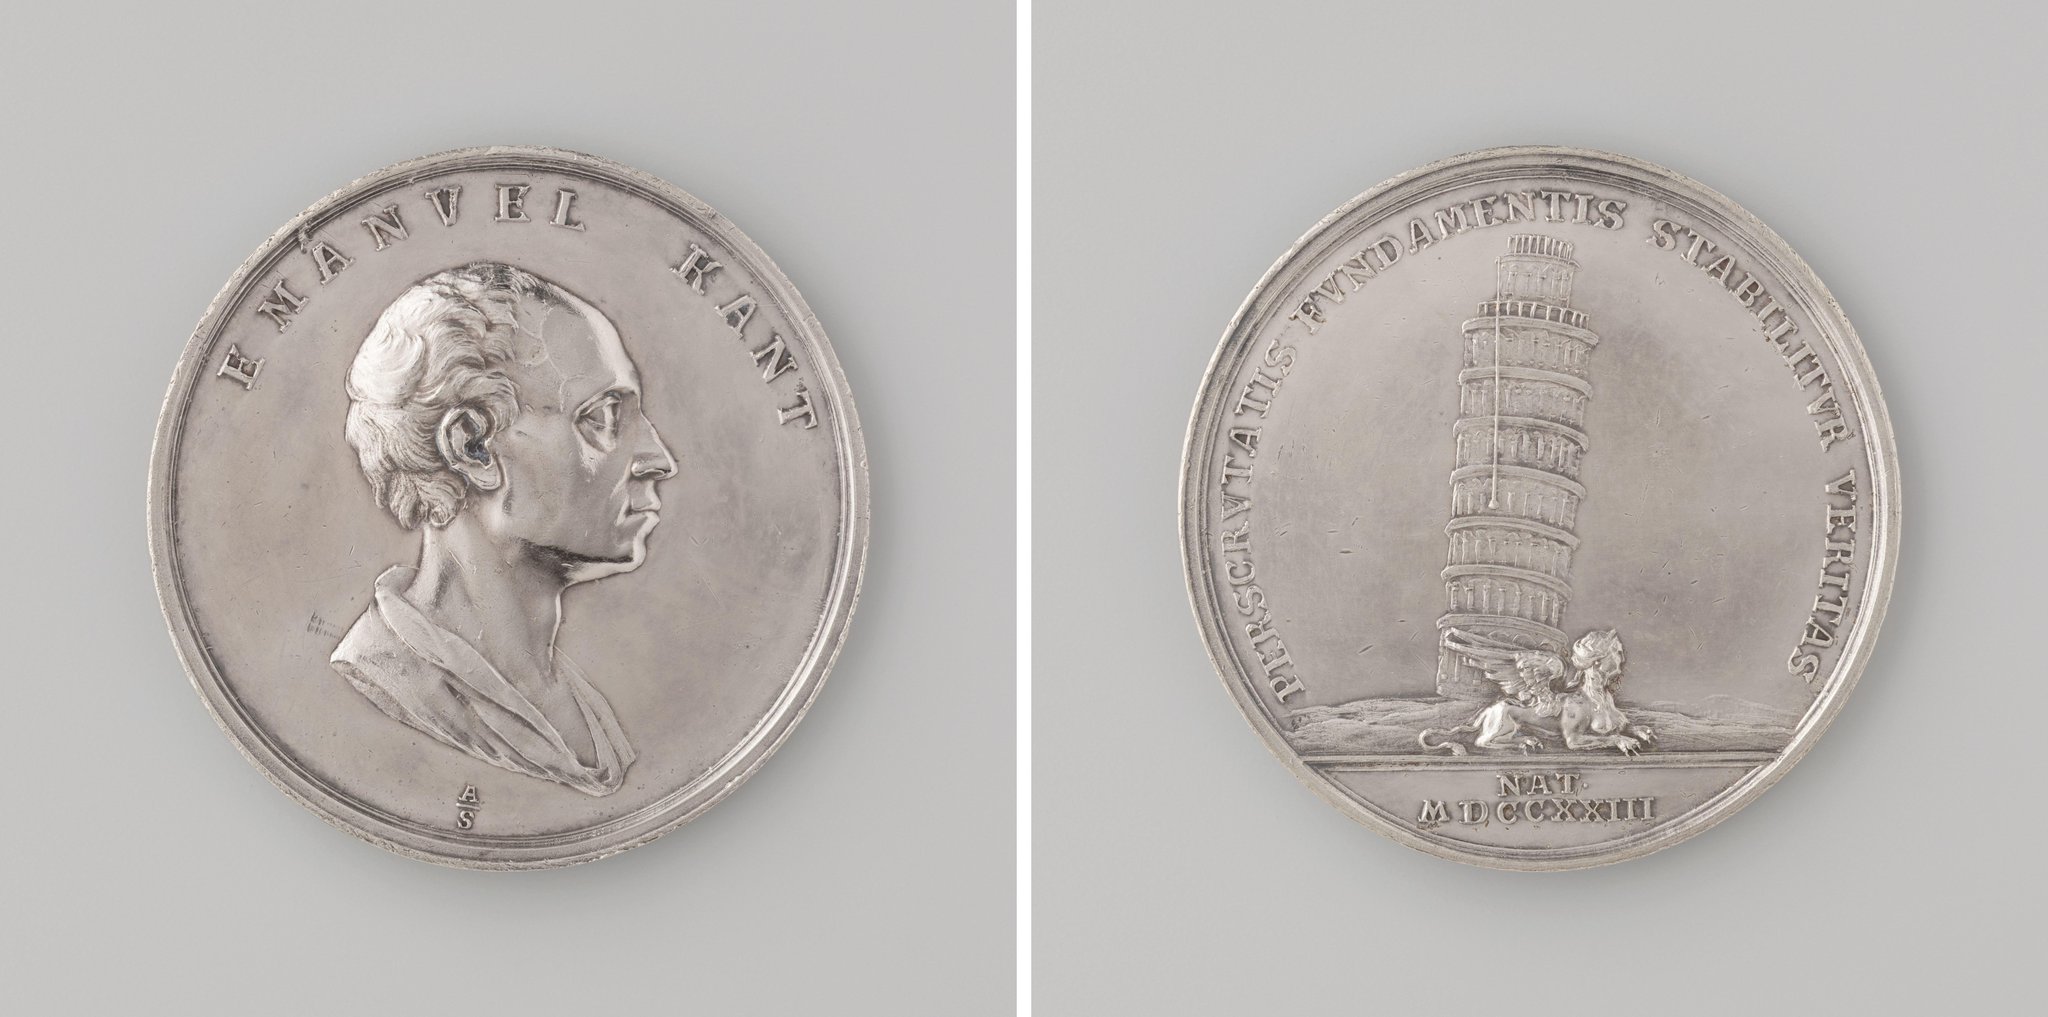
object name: verjaardagspenning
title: Zestigste verjaardag van Immanuel Kant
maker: abraham abramson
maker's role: medailleur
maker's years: 1754-1811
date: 1784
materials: silver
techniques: striking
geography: berlin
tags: immanuel kant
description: Zilveren penning. Voorzijde: borststuk man binnen omschrift. Keerzijde: sfinx zittend aan voet van toren van Pisa binnen omschrift; afsnede: datering. Deze medaille werd gemaakt te ere van Kant zijn zestigste verjaardag, en werd besteld en betaald door een groep van zijn studenten.